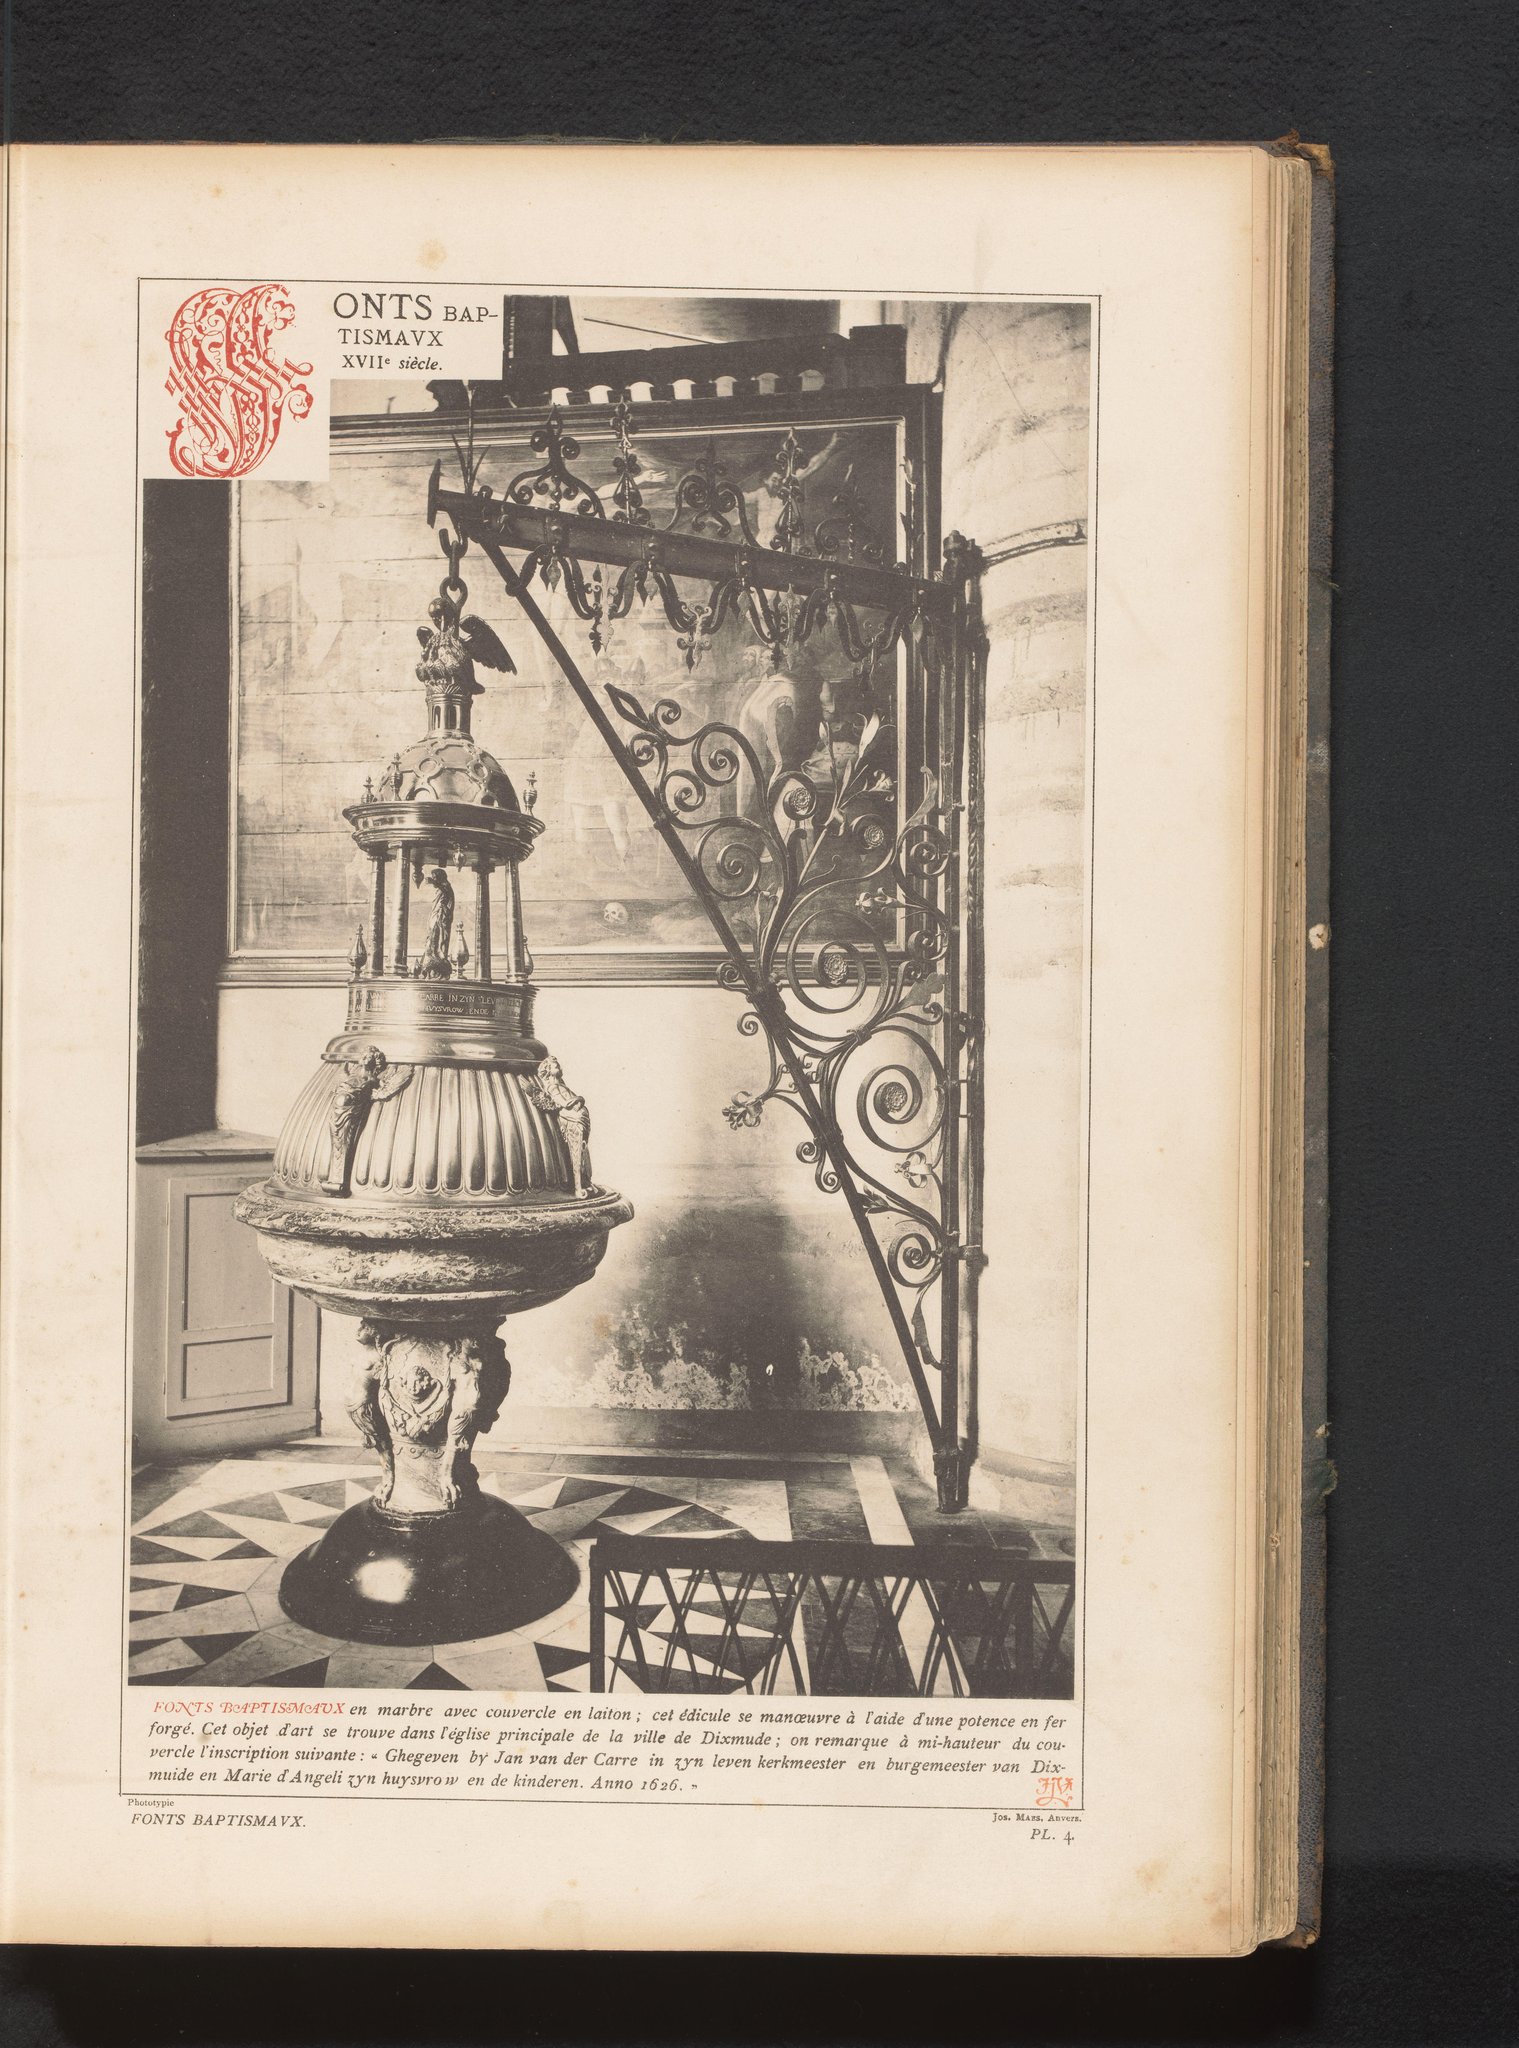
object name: photomechanical print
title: Doopvont van marmer en messing in de Sint-Niklaaskerk in Diksmuide, België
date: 1882-1887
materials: paper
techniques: photograph, photolithography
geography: diksmuide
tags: baptismal font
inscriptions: inscription: ‘FONTS BAPTISMAUX en (...)’, monogram: ‘JJvY’, inscription: ‘FONTS BAPTISMAUX. - PL. 4.’